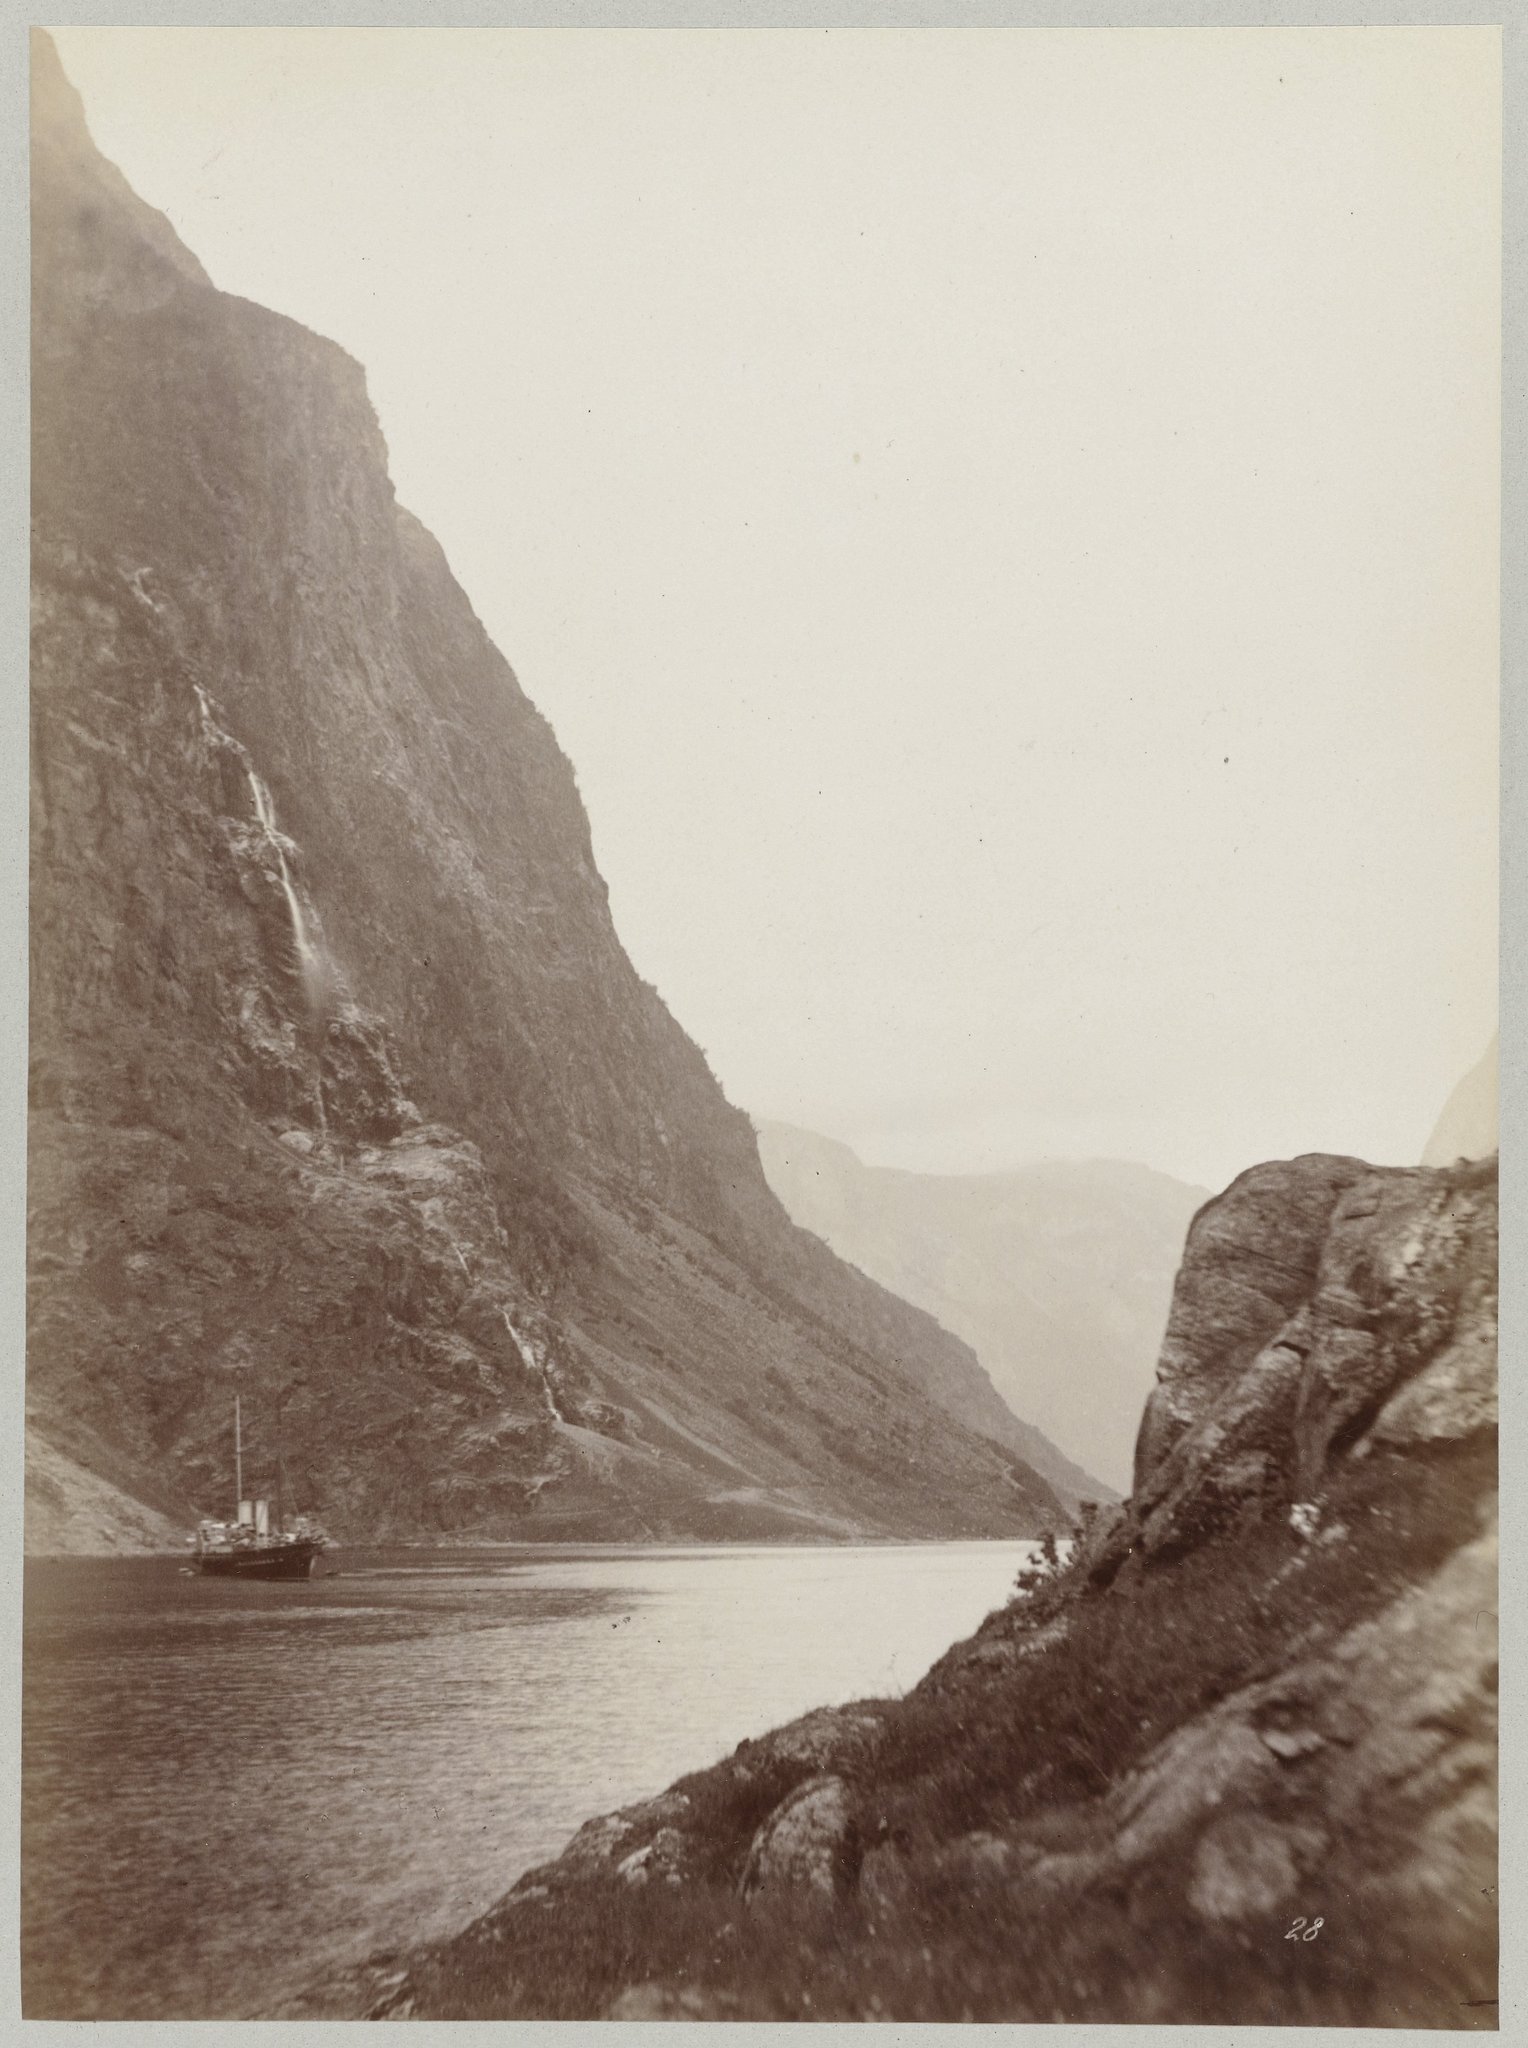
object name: photograph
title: Im Näröfjord bei Gudwangen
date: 1807-1889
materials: cardboard, paper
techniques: albumen print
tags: wilhelm ii (keizer van duitsland), norway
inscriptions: number: ‘15’, number: ‘28’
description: De afdruk van de foto is rond, het papier vierkant